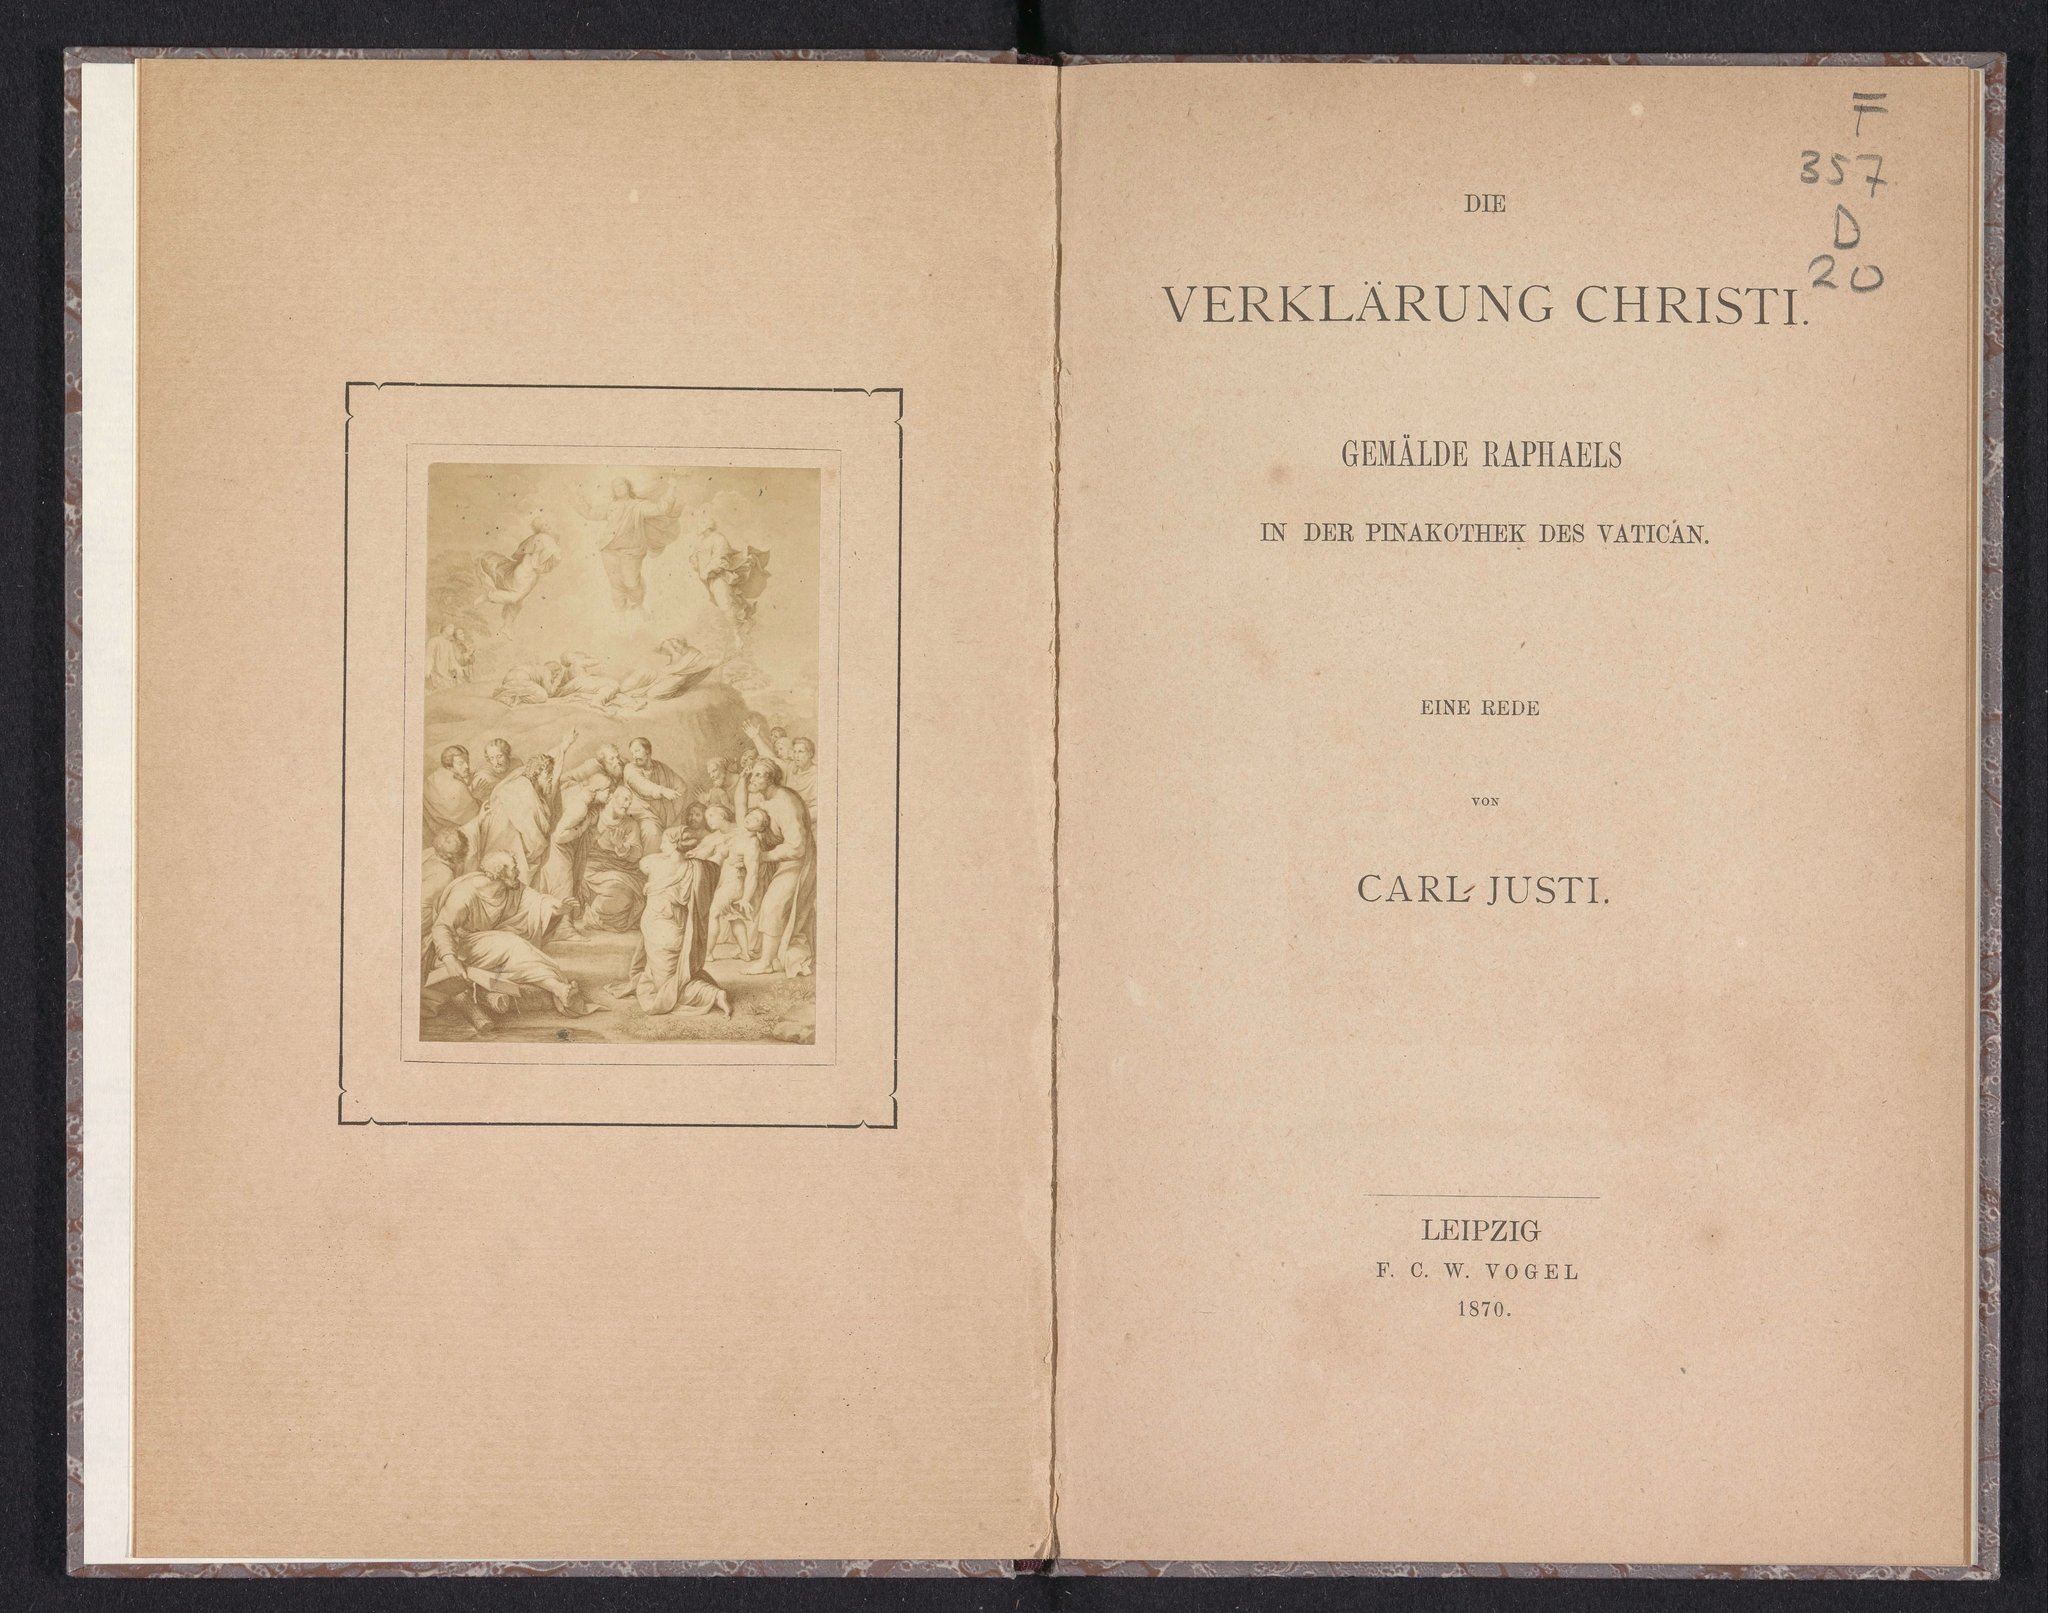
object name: page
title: Fotoreproductie van een prent naar een schilderij, voorstellende de Transfiguratie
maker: Anonymous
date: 1865-1870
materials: photographic support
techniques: albumen print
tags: the transfiguration: moses and elijah appear on either side of christ on mount tabor (matthew 17:1-13; mark 9:2-13; luke 9:28-36)